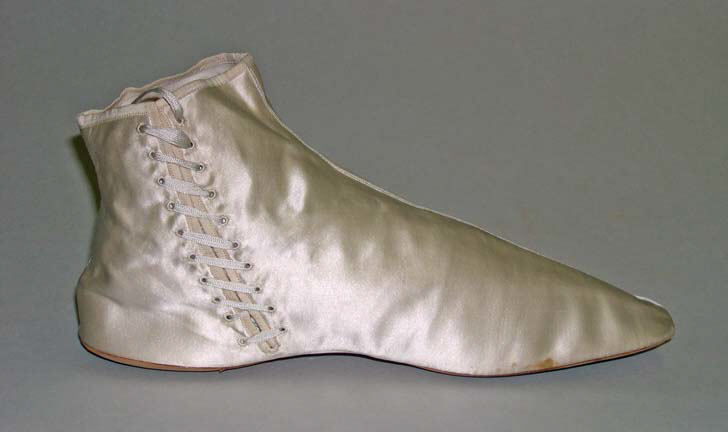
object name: wedding slipper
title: Wedding slippers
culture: american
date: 1856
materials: leather